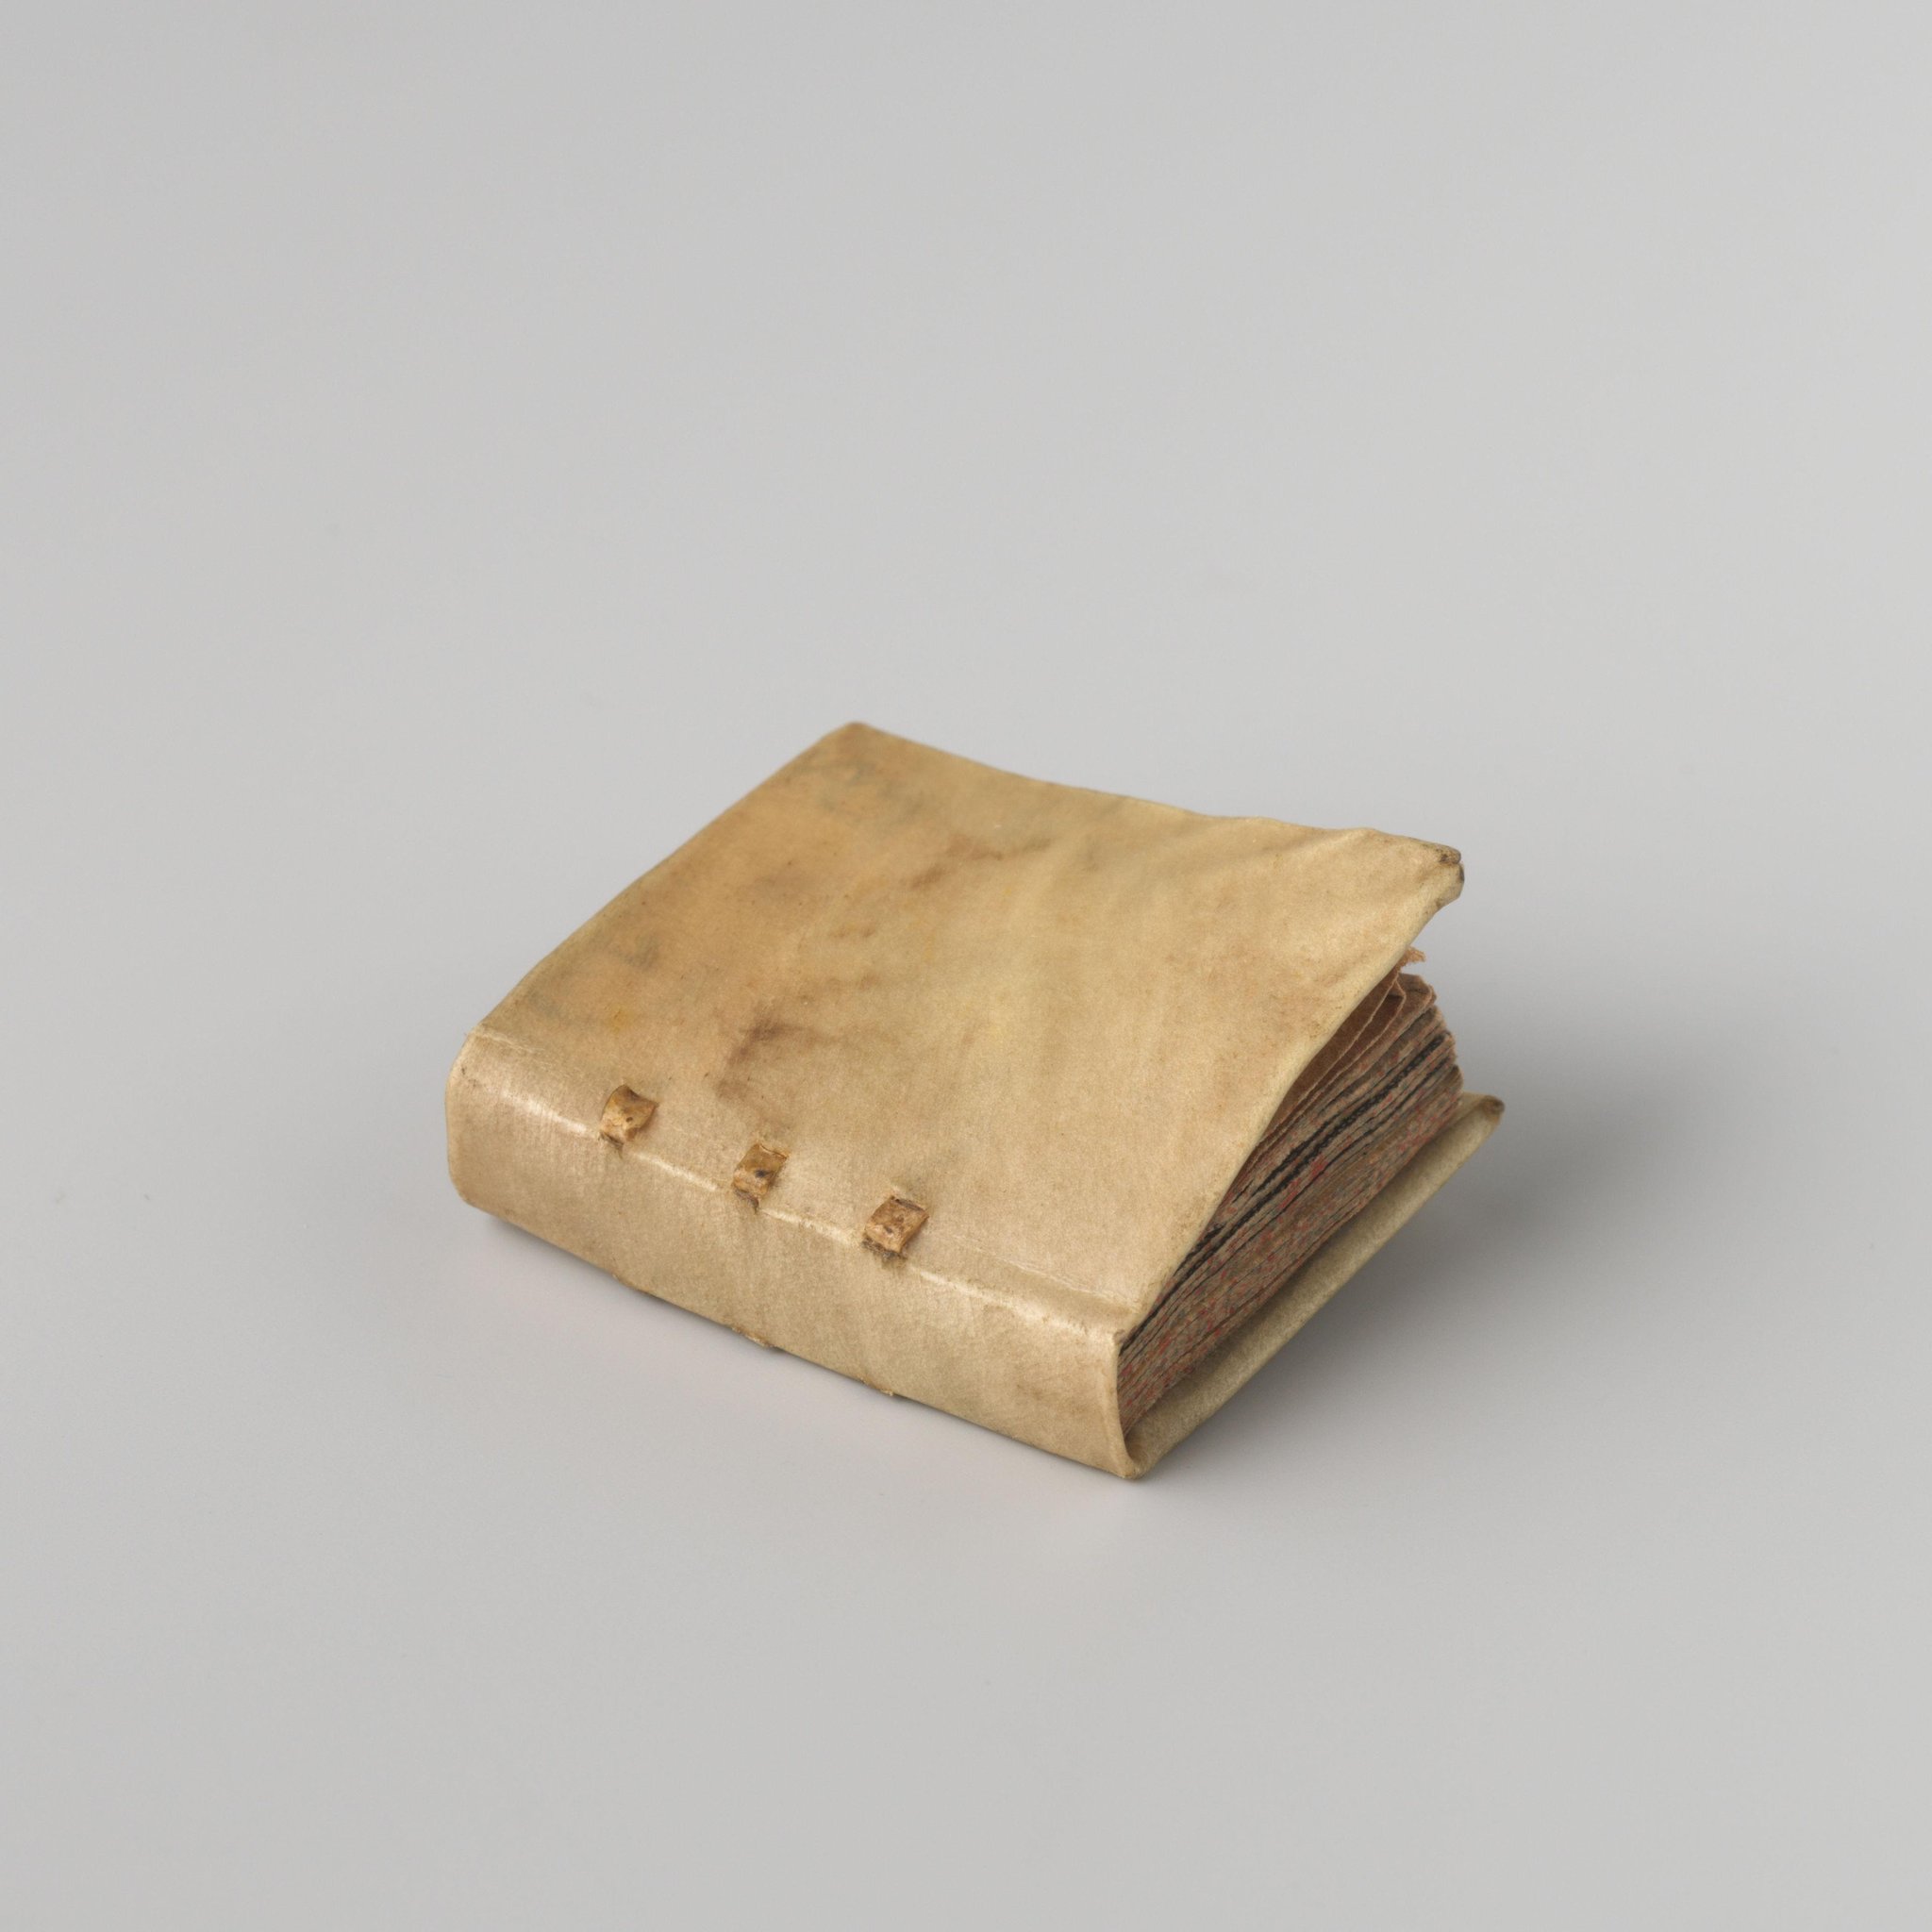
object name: miniature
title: Boek met Engelse stadsprofielen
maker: Anonymous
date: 1690-1710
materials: paper, parchment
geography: amsterdam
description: Boek met Engelse stadsprofielen. Ingebonden in blank perkament. De splitsband van hergebruikt perkament bevat drie katernen van vier bladen, waarvan beide bladzijden, doorlopend over de middennaad, zijn beplakt met prenten van Engelse stadsprofielen: achtereenvolgens Carlisle, Ipswich, Newcastle, Cambridge, Winchester, Lincolne, Norwich, Yorke, Worchester, Nottingham en Excester.